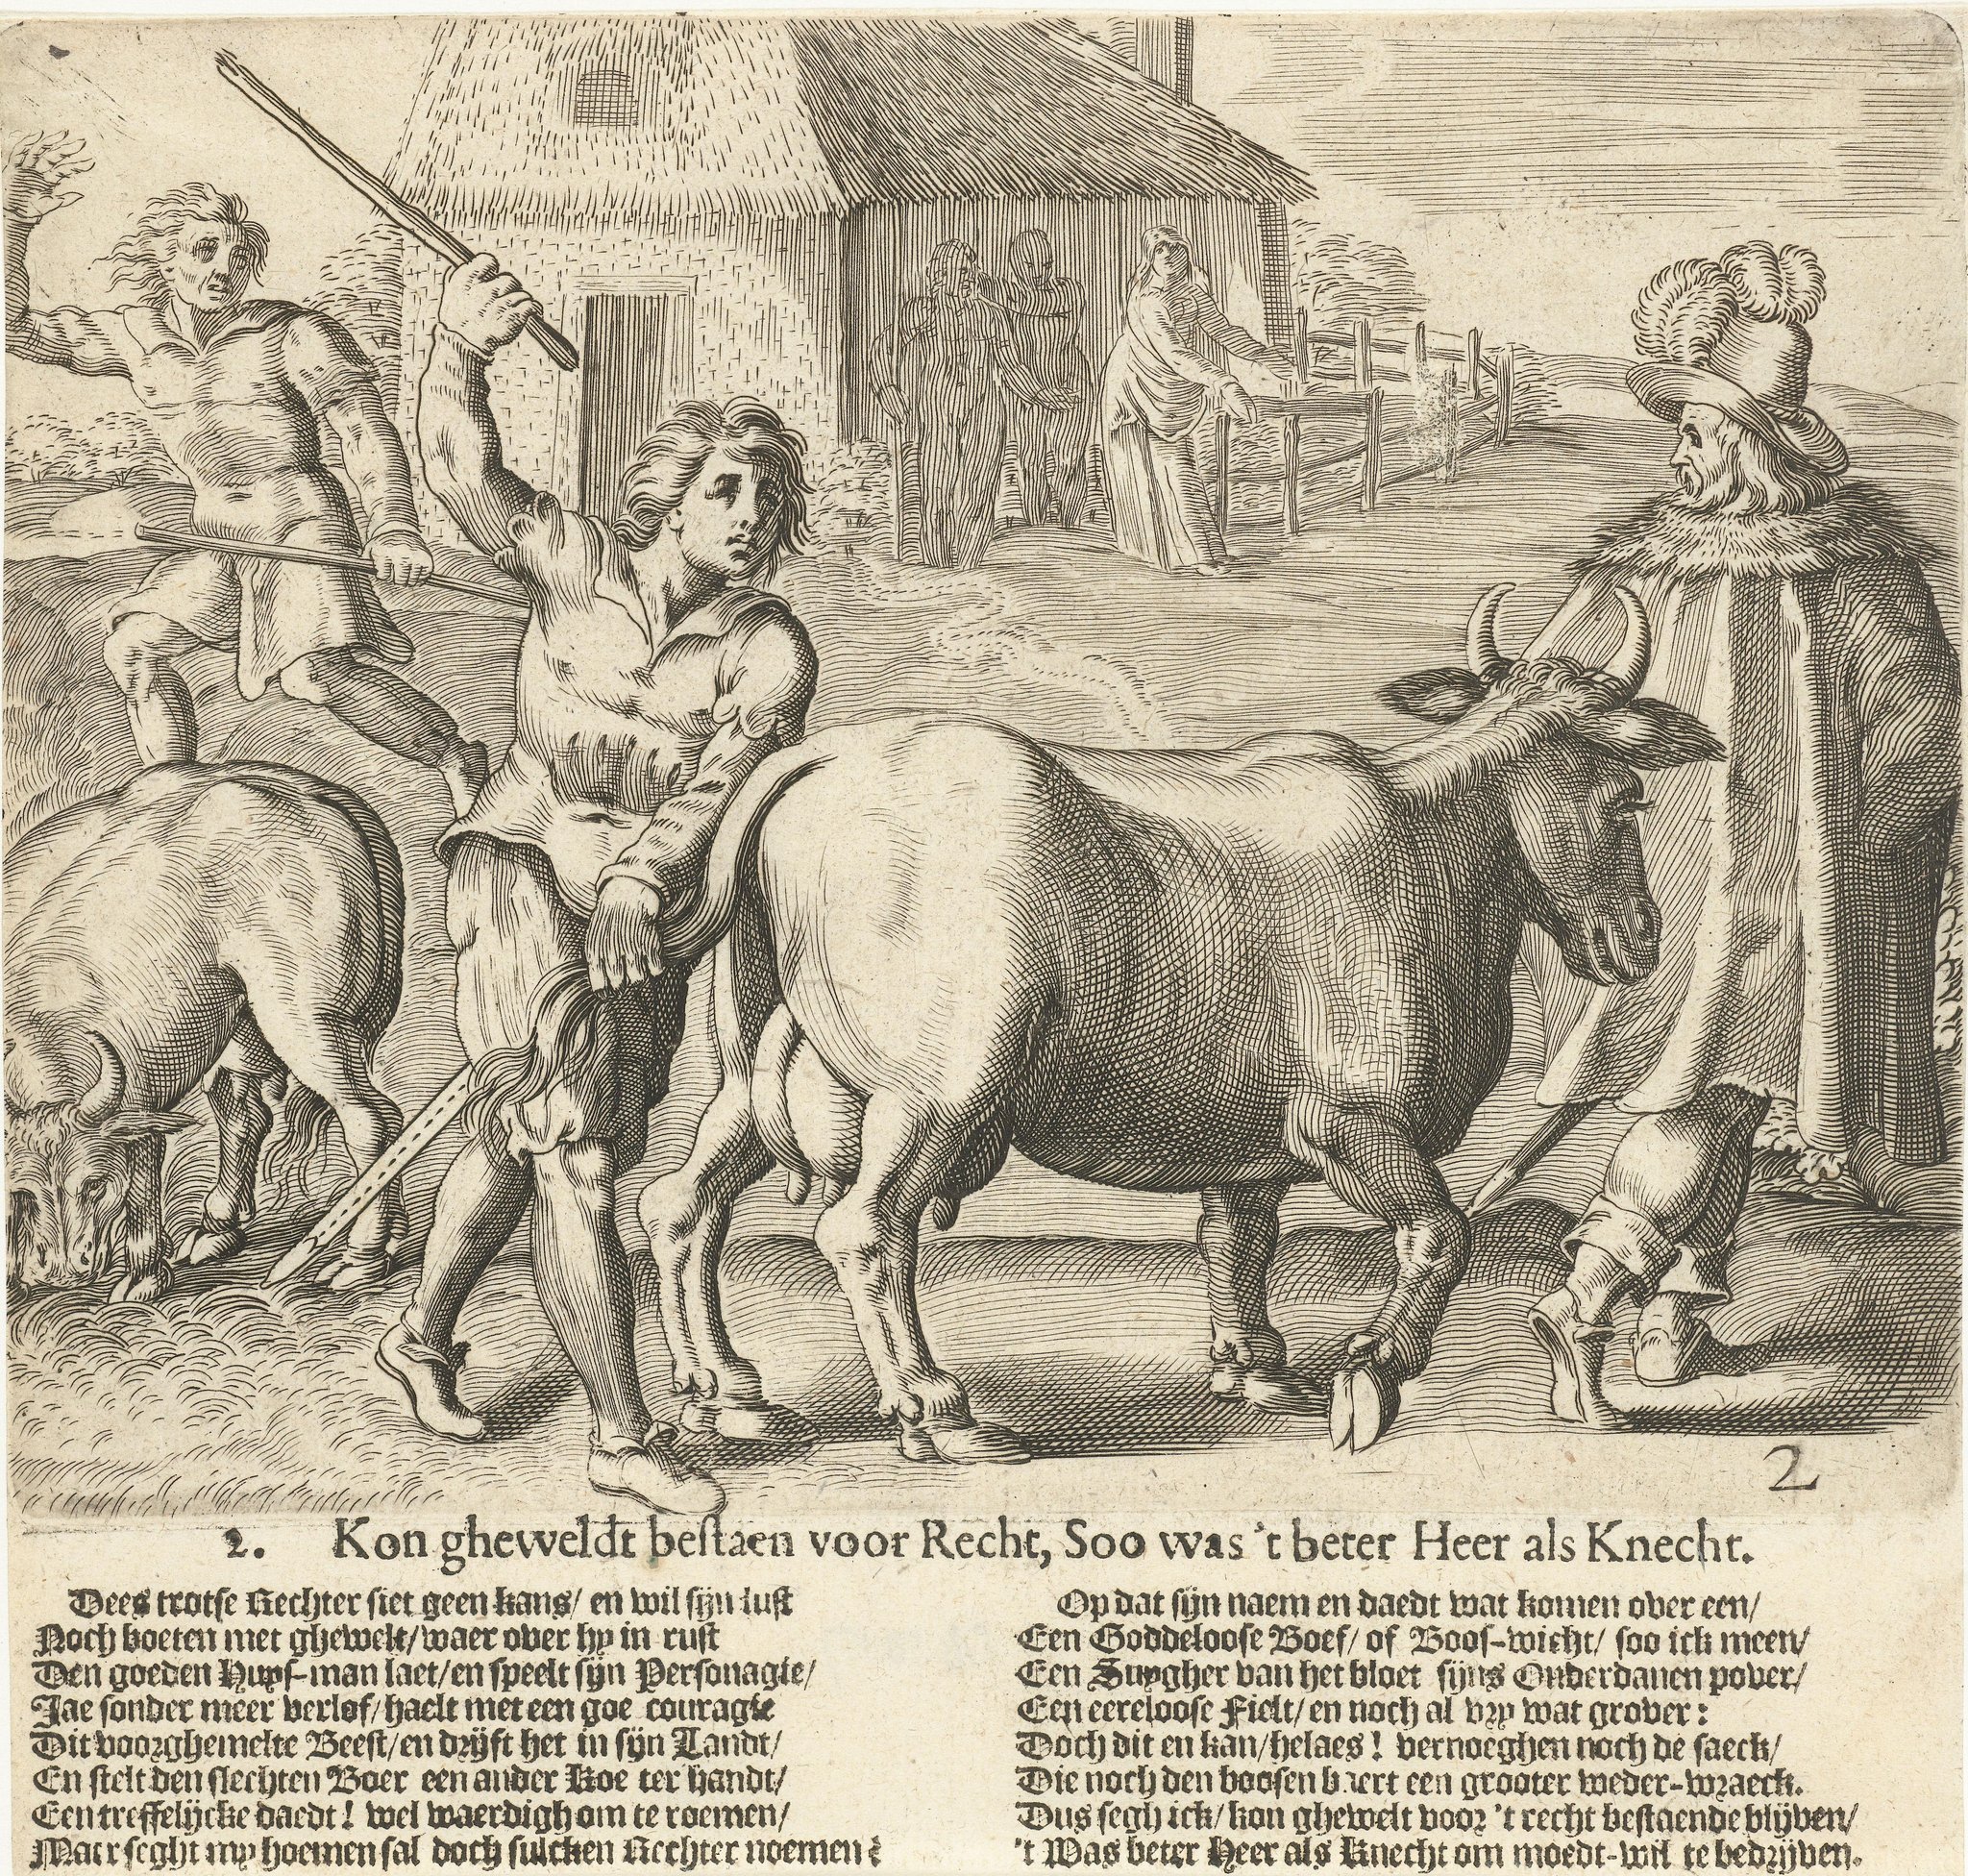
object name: history print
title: 2. Kon gheweldt bestaen voor Recht, Soo was 't beter Heer als Knecht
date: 1613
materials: paper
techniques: engraving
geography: amsterdam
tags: willem iii de goede (graaf van holland en henegouwen), cow, netherlands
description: De baljuw voert de koe van de boer weg na deze omgeruild te hebben voor een minder exemplaar. Op de achtergrond ziet de boer met zijn gezin hulpeloos toe. Voorstelling nr. 2 in een serie van zes kleine scènes van de opeenvolgende episoden van het verhaal van de Rechtspraak van graaf Willem III in het jaar 1336. Deze kleine prenten behoren aan weerszijden van de grote centrale voorstelling. Bij elke voorstelling een onderschrift bestaande uit een spreuk en een vers van twee kolommen van acht regels.